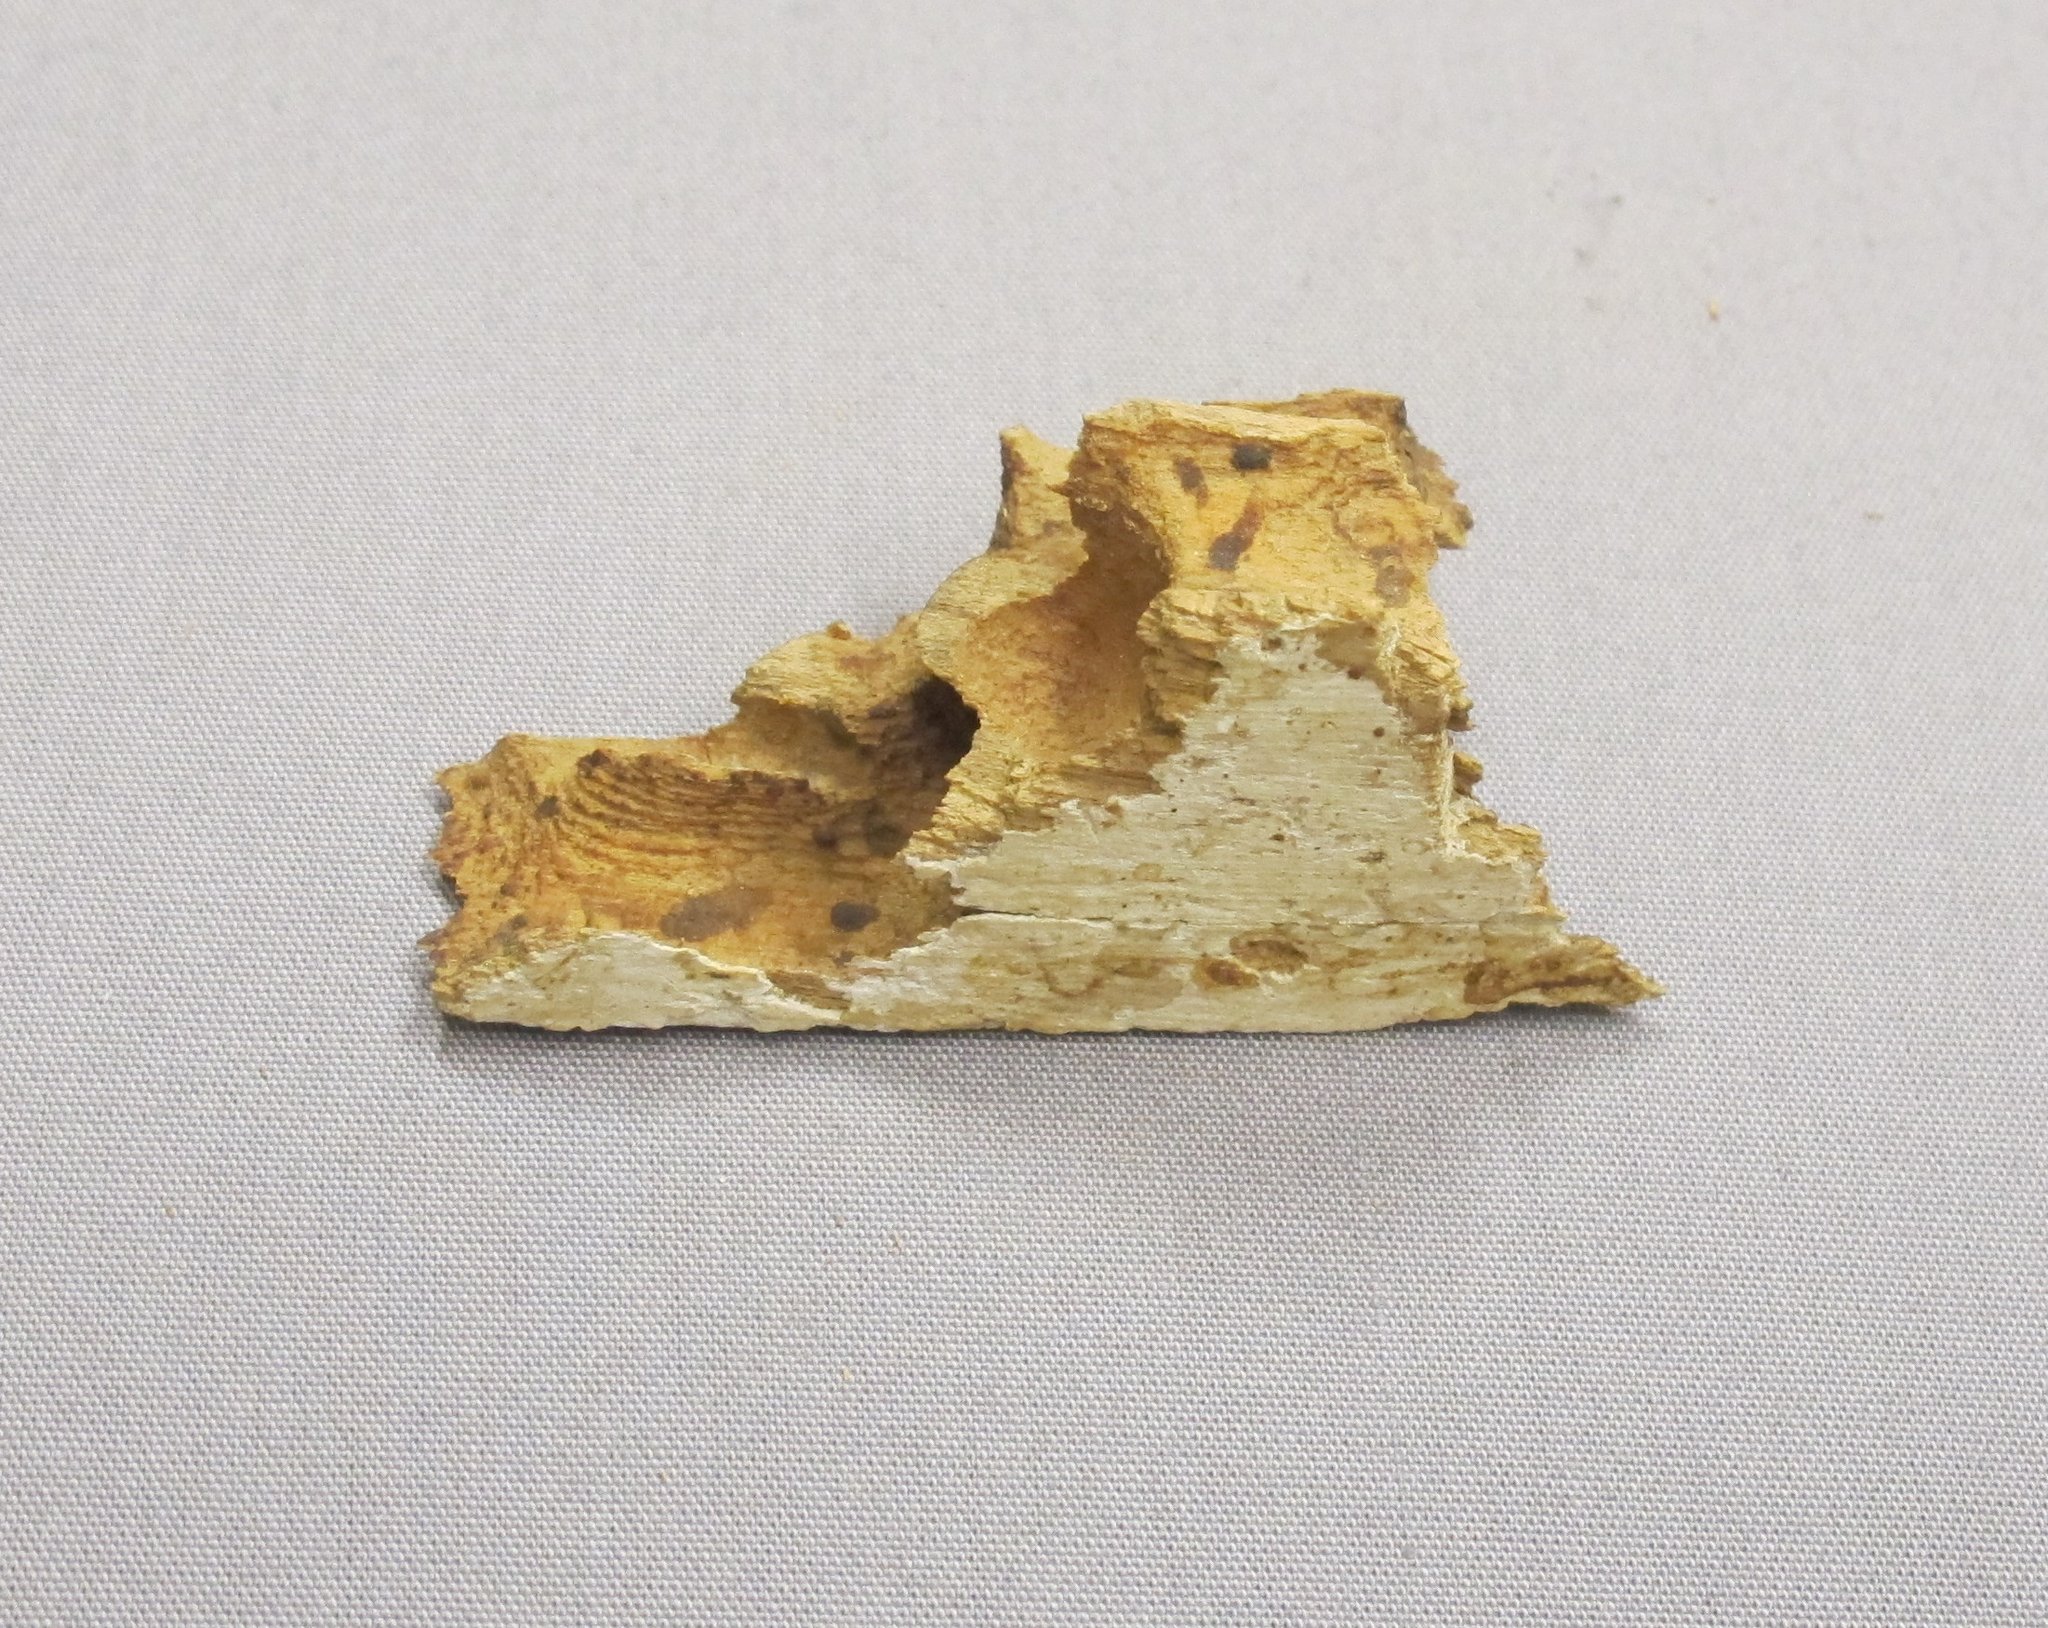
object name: door fragment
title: Fragment from a tomb door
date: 2150-1981 BCE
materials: paint, wood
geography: egypt